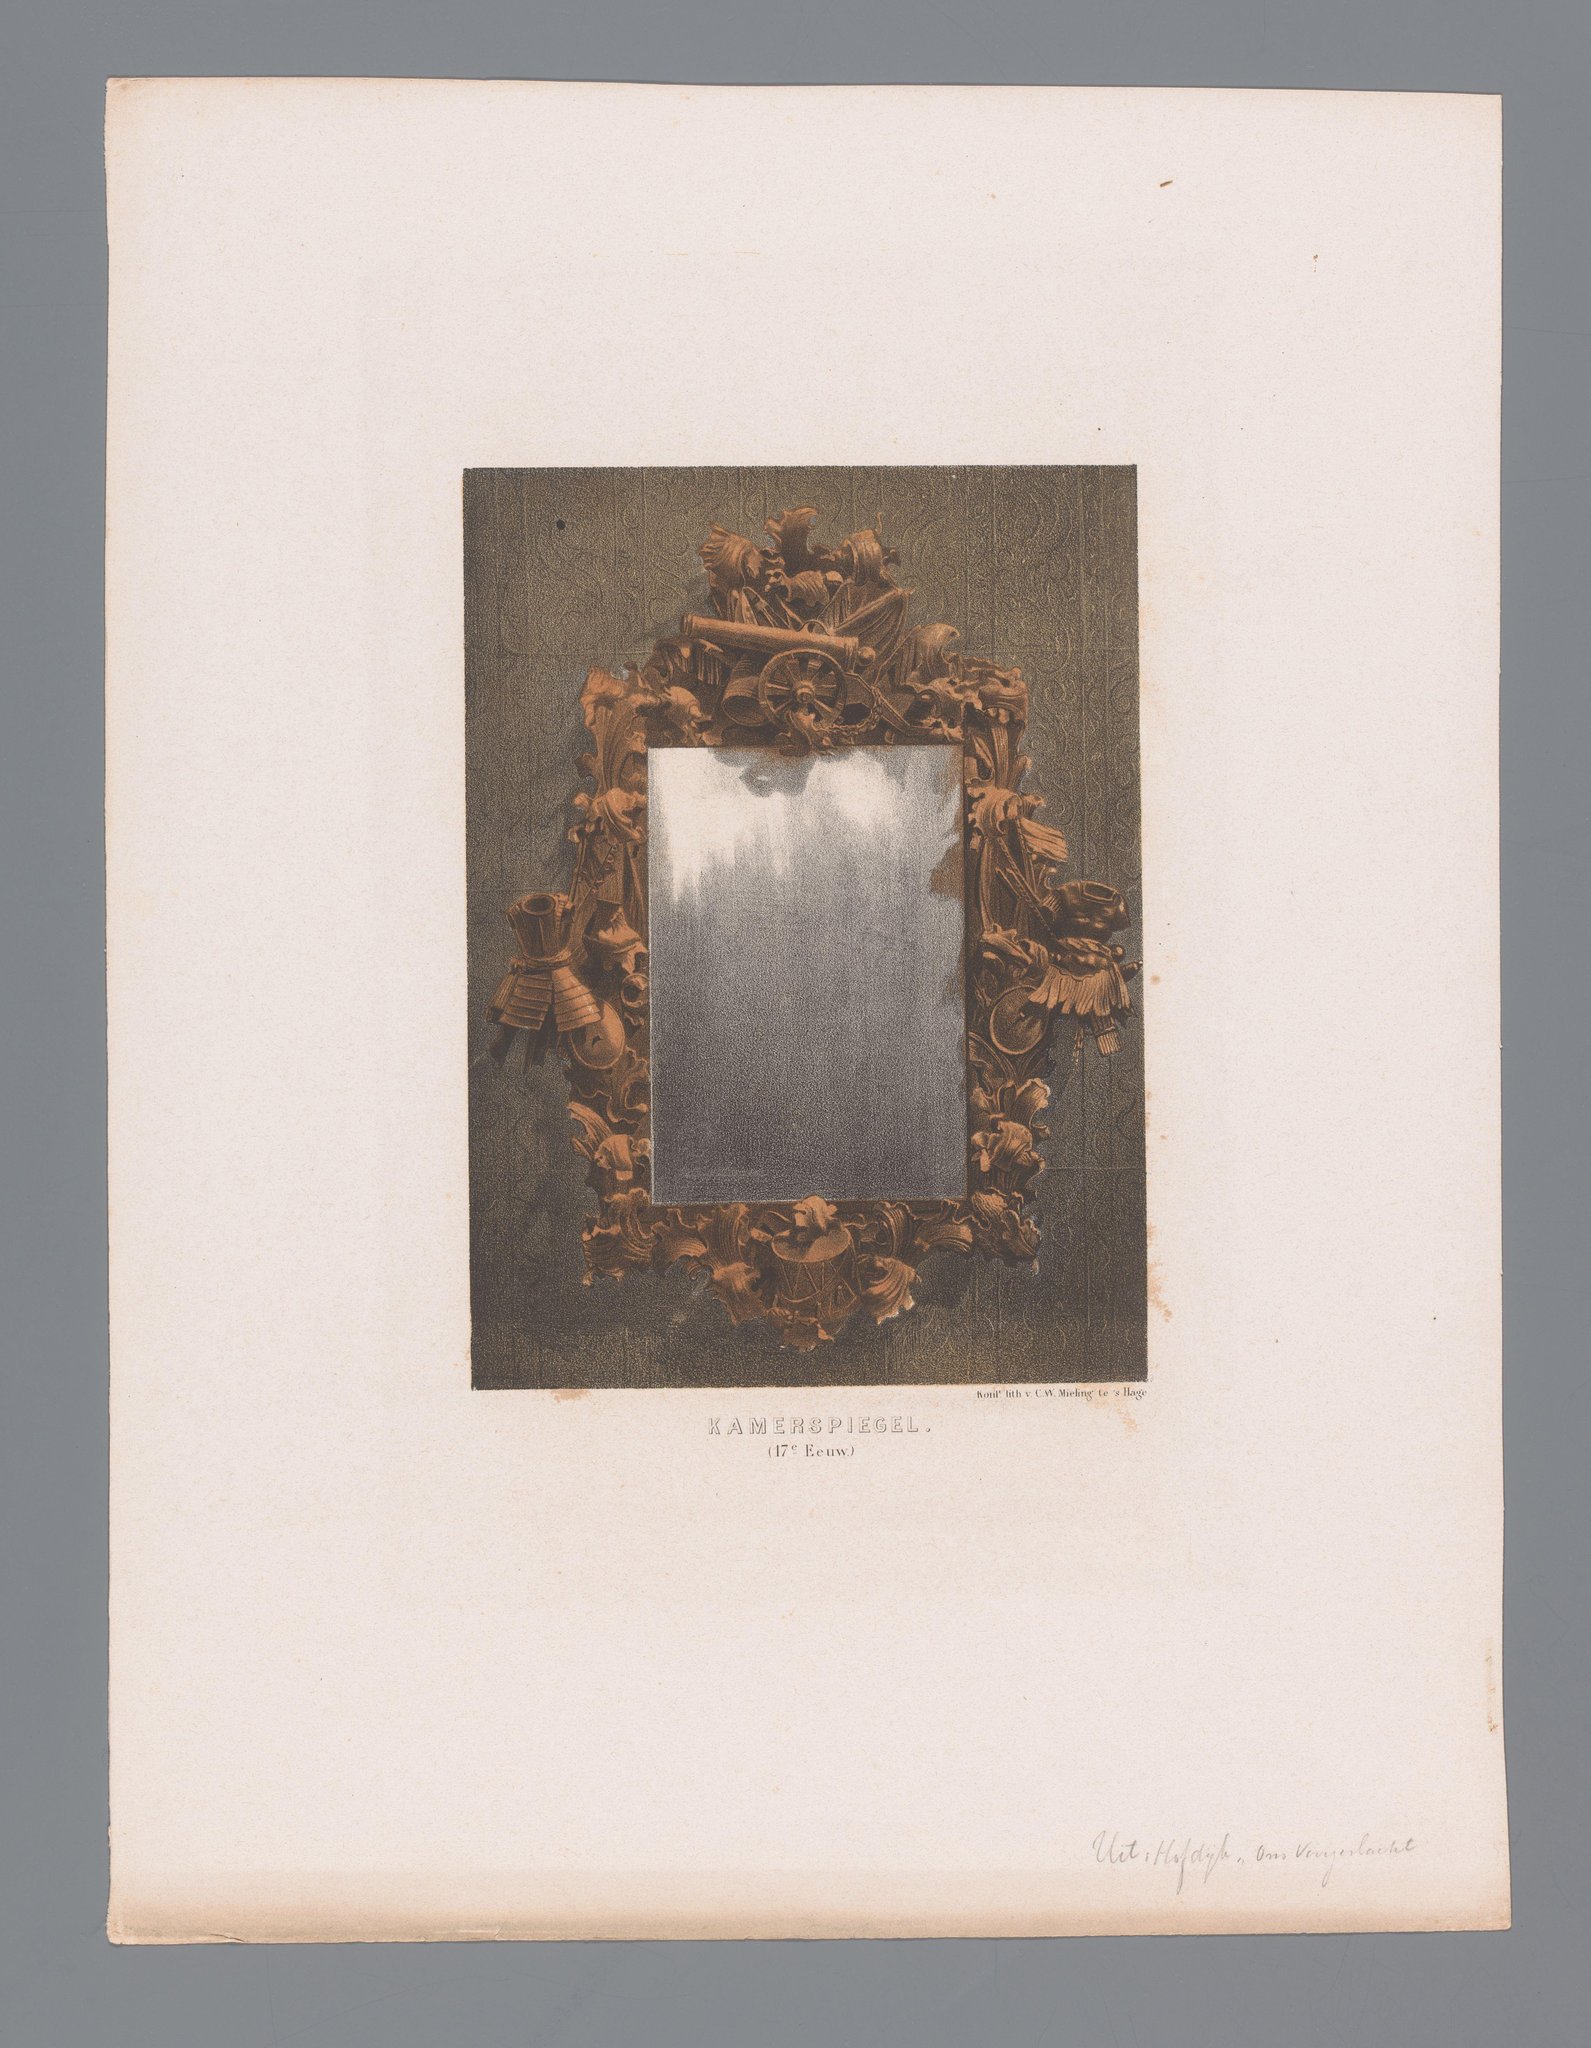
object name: print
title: Kamerspiegel (17e eeuw)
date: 1864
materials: paper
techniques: tone lithography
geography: haarlem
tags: mirror, firearms: cannon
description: In de lijst zitten objecten verwerkt die verwijzen naar oorlog zoals een kanon, harnas en trom.